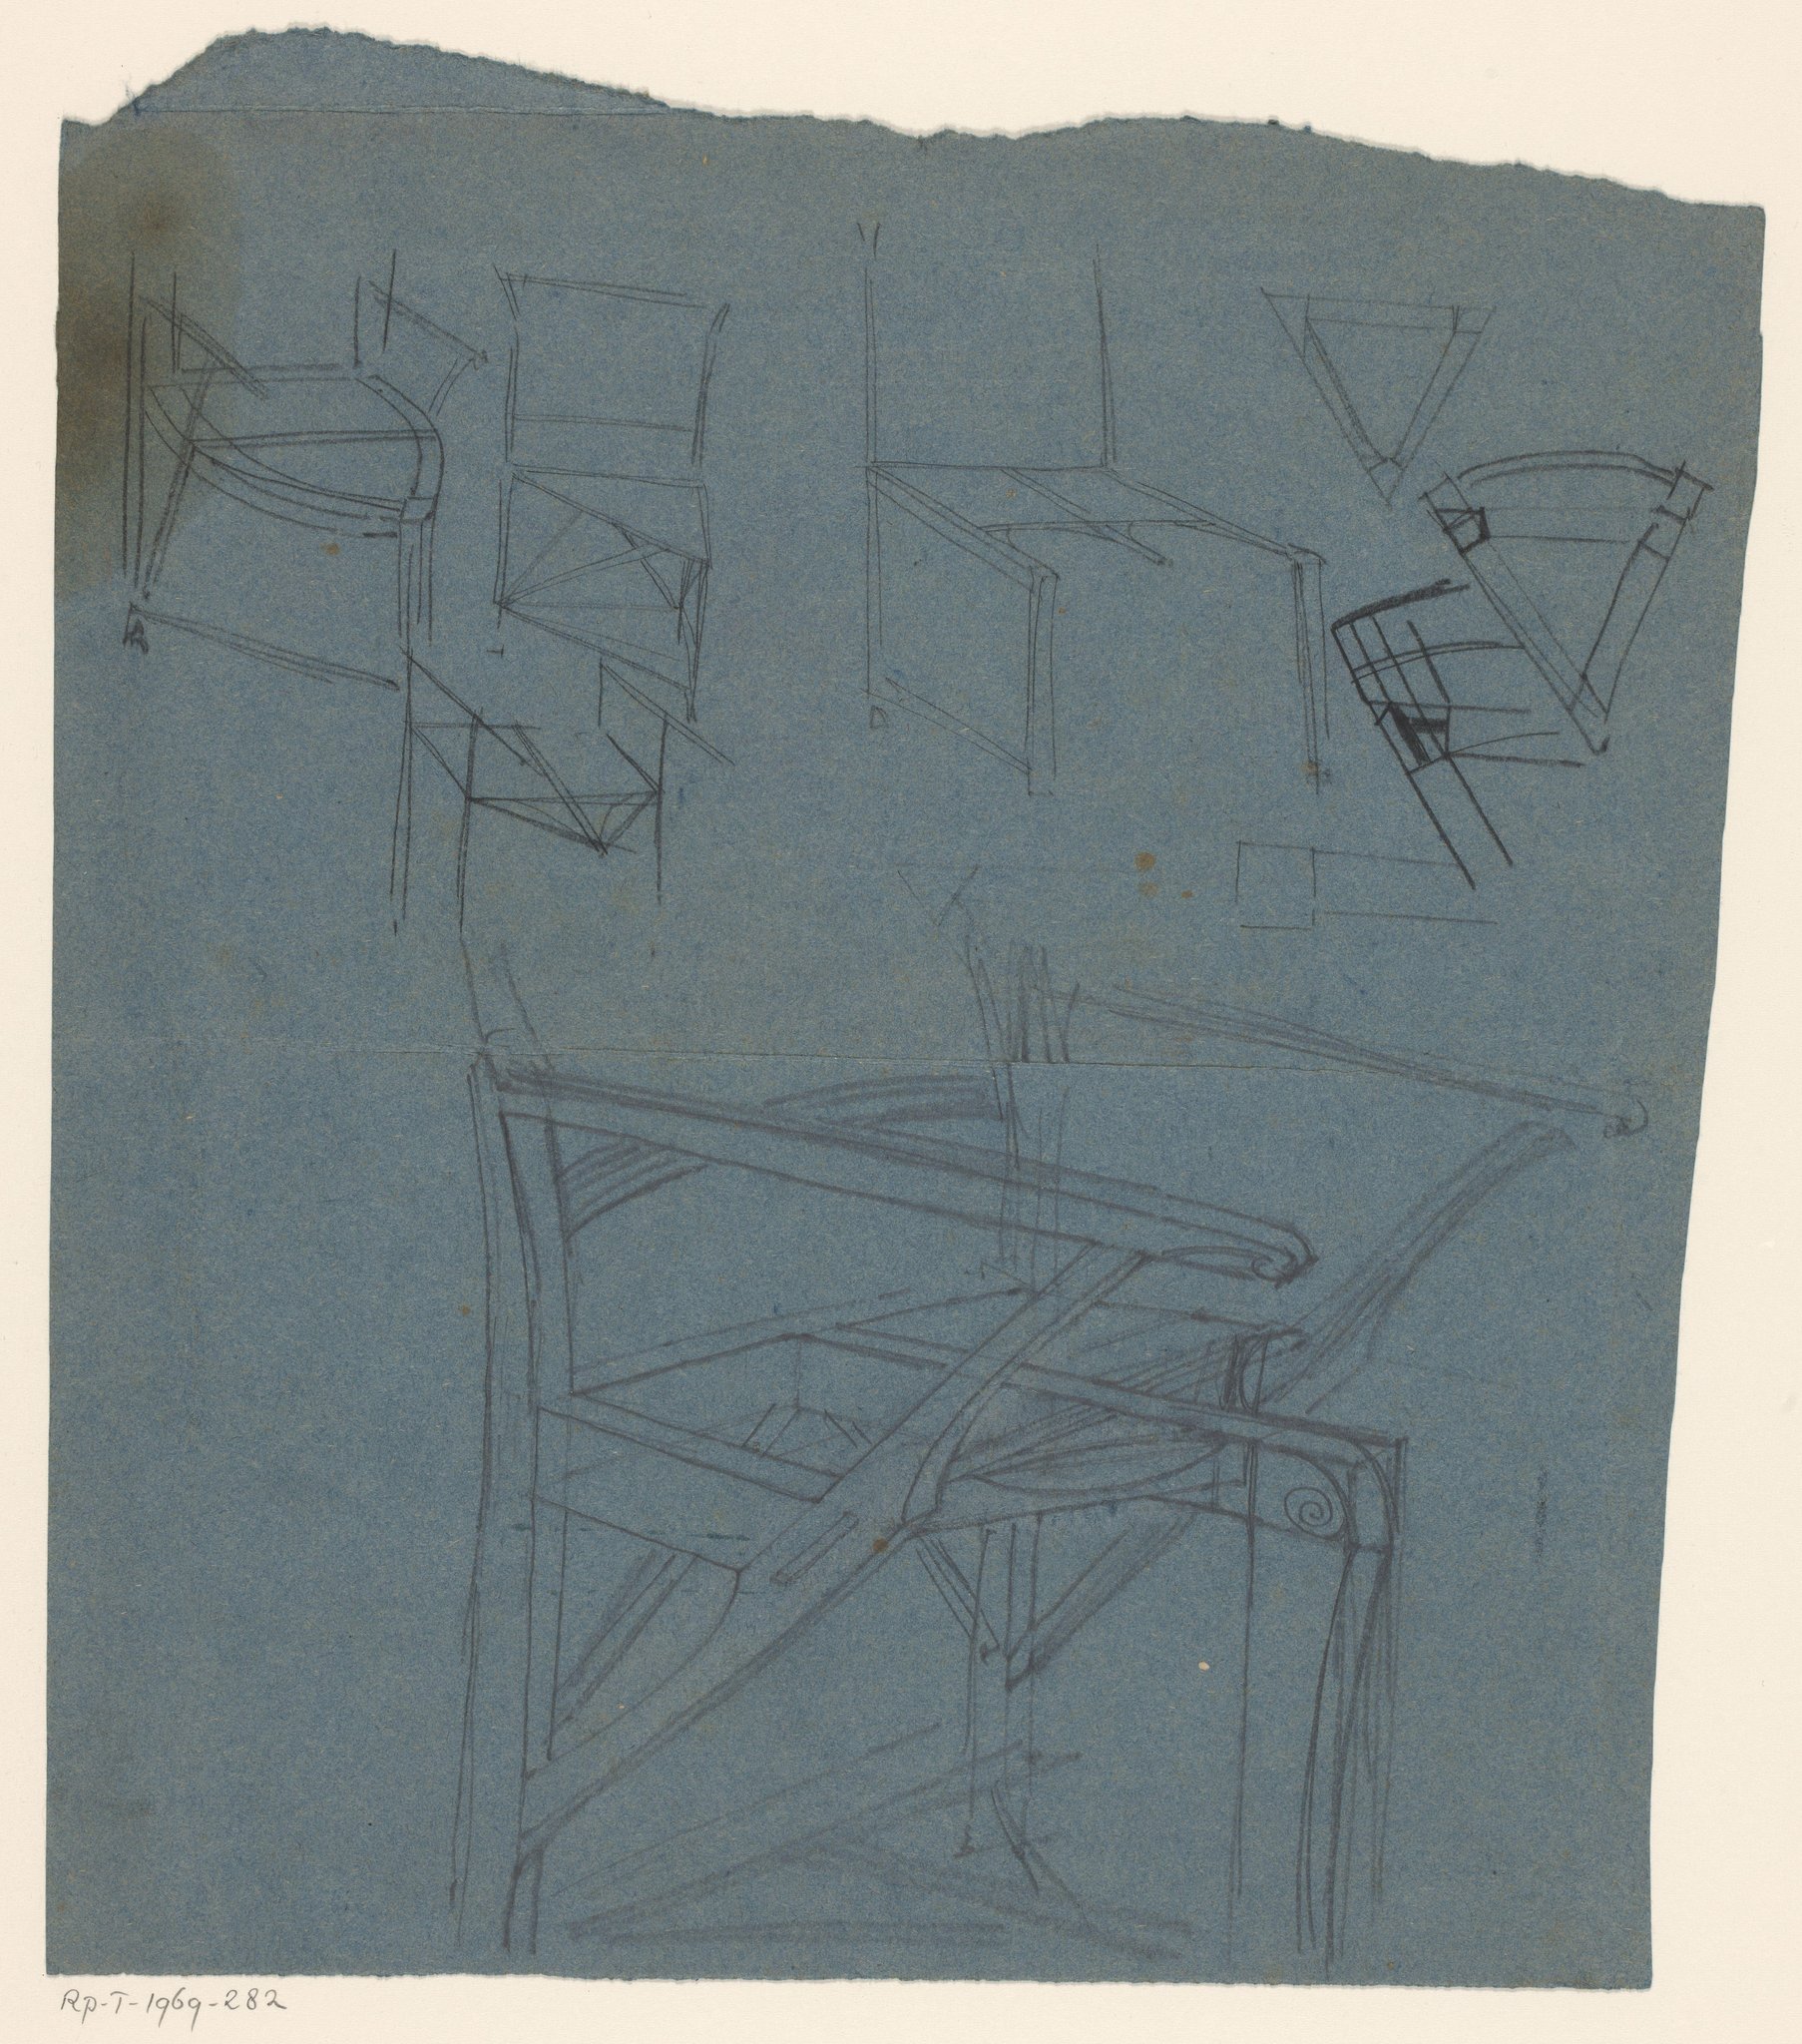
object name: design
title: Ontwerpen voor een stoel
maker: gerrit willem dijsselhof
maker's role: designer, draughtsman, print maker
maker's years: 1866-1924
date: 1876-1924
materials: chalk, paper, pencil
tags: chair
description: Ontwerpen voor een stoel op de achterkant van een litho van de Handperssteendrukinrichting 'De Ster'.